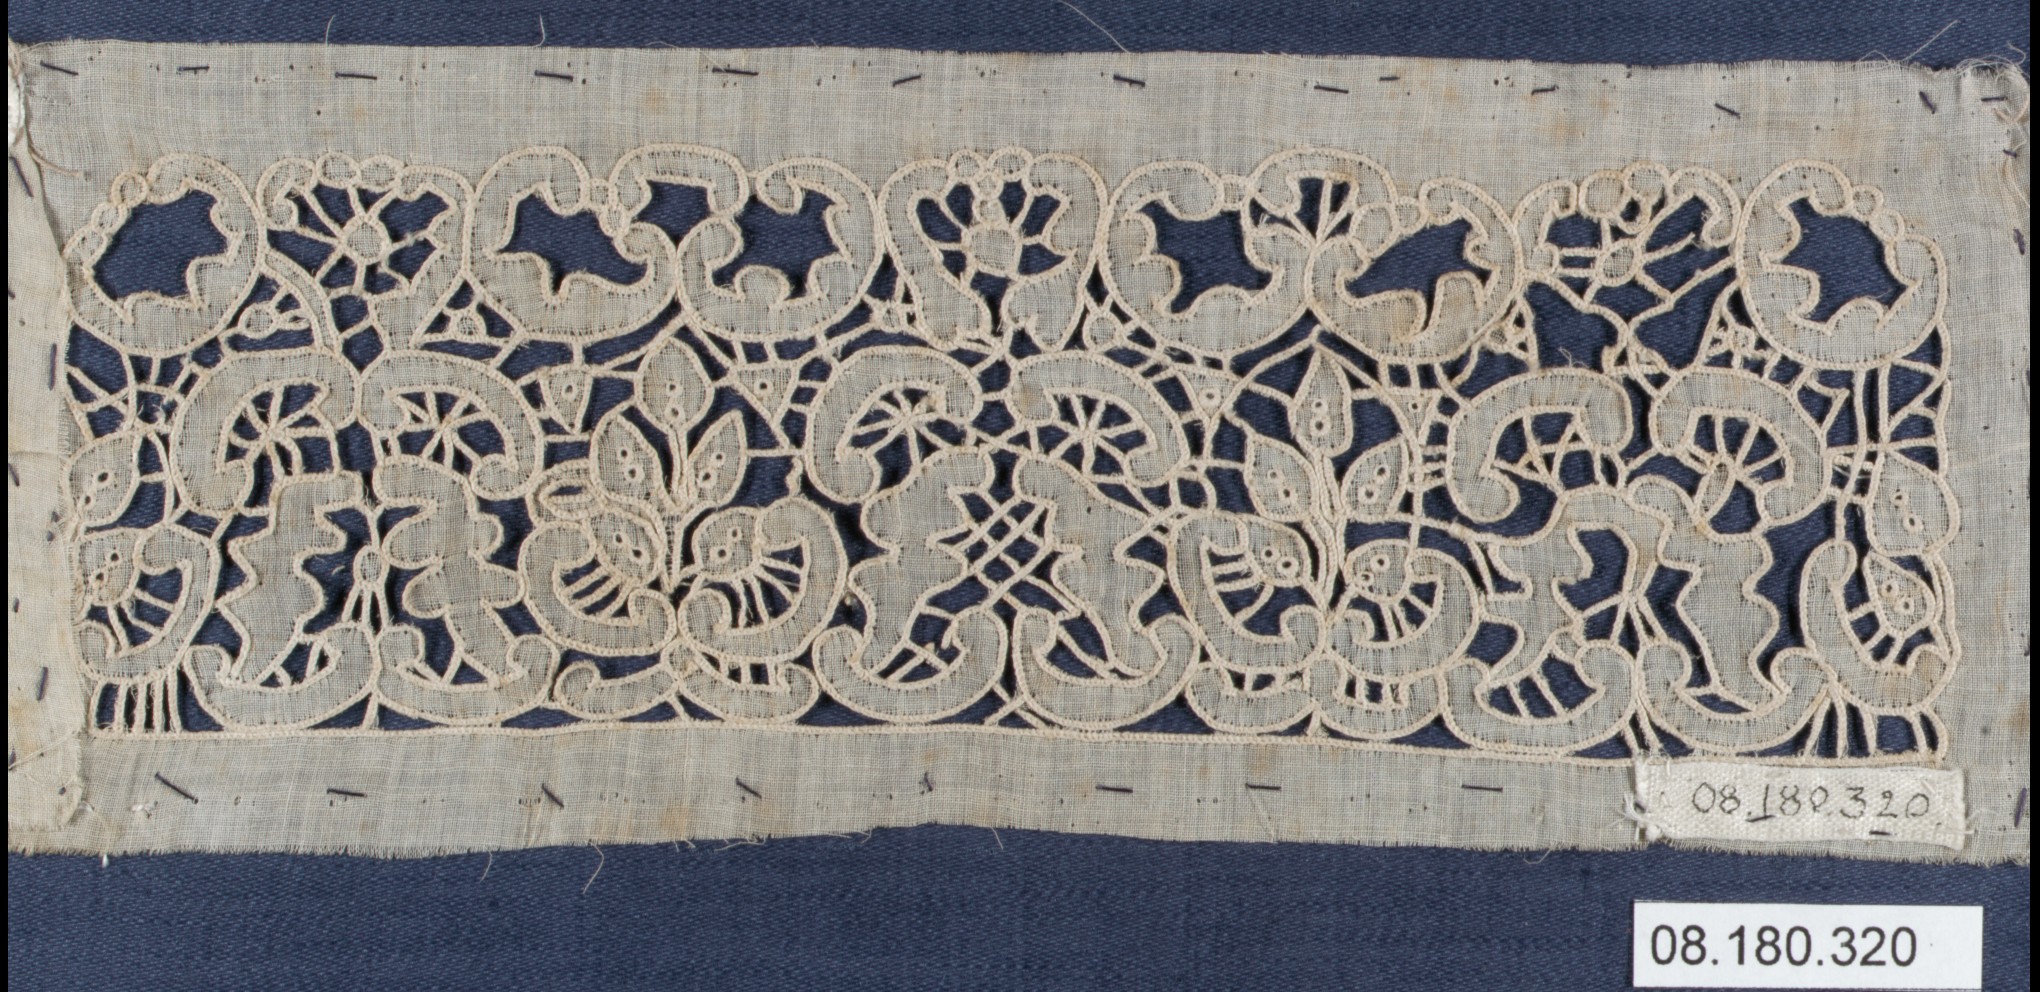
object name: cuff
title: Cuffs (one of a pair)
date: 1701-1800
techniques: embroidery